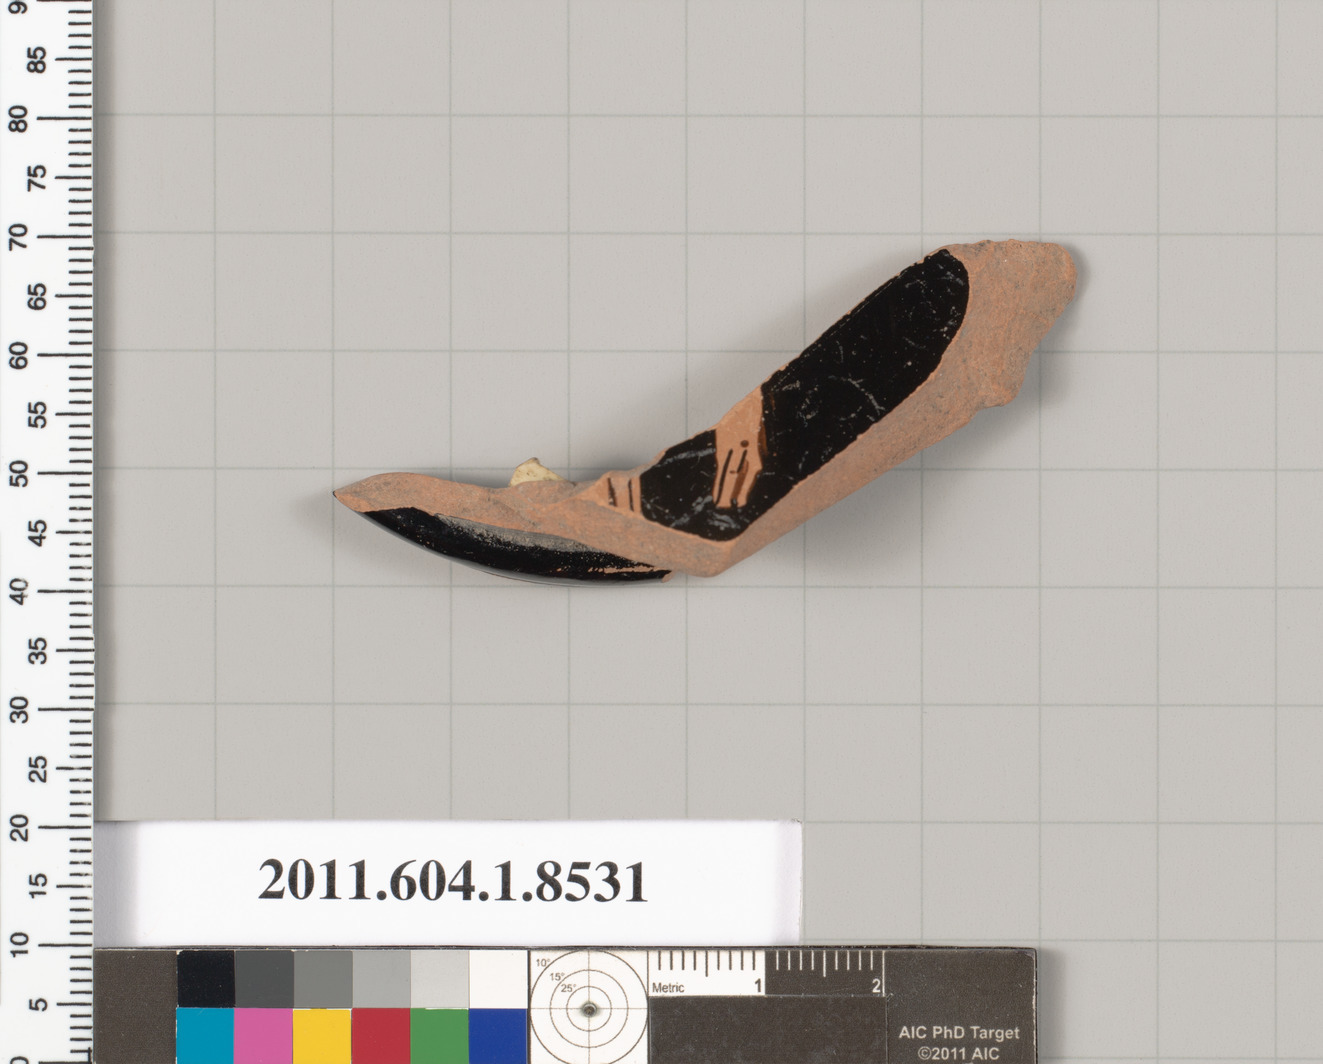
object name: kylix fragment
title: Terracotta fragment of a stemless kylix (drinking cup)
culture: greek, attic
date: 467-435 BCE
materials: terracotta